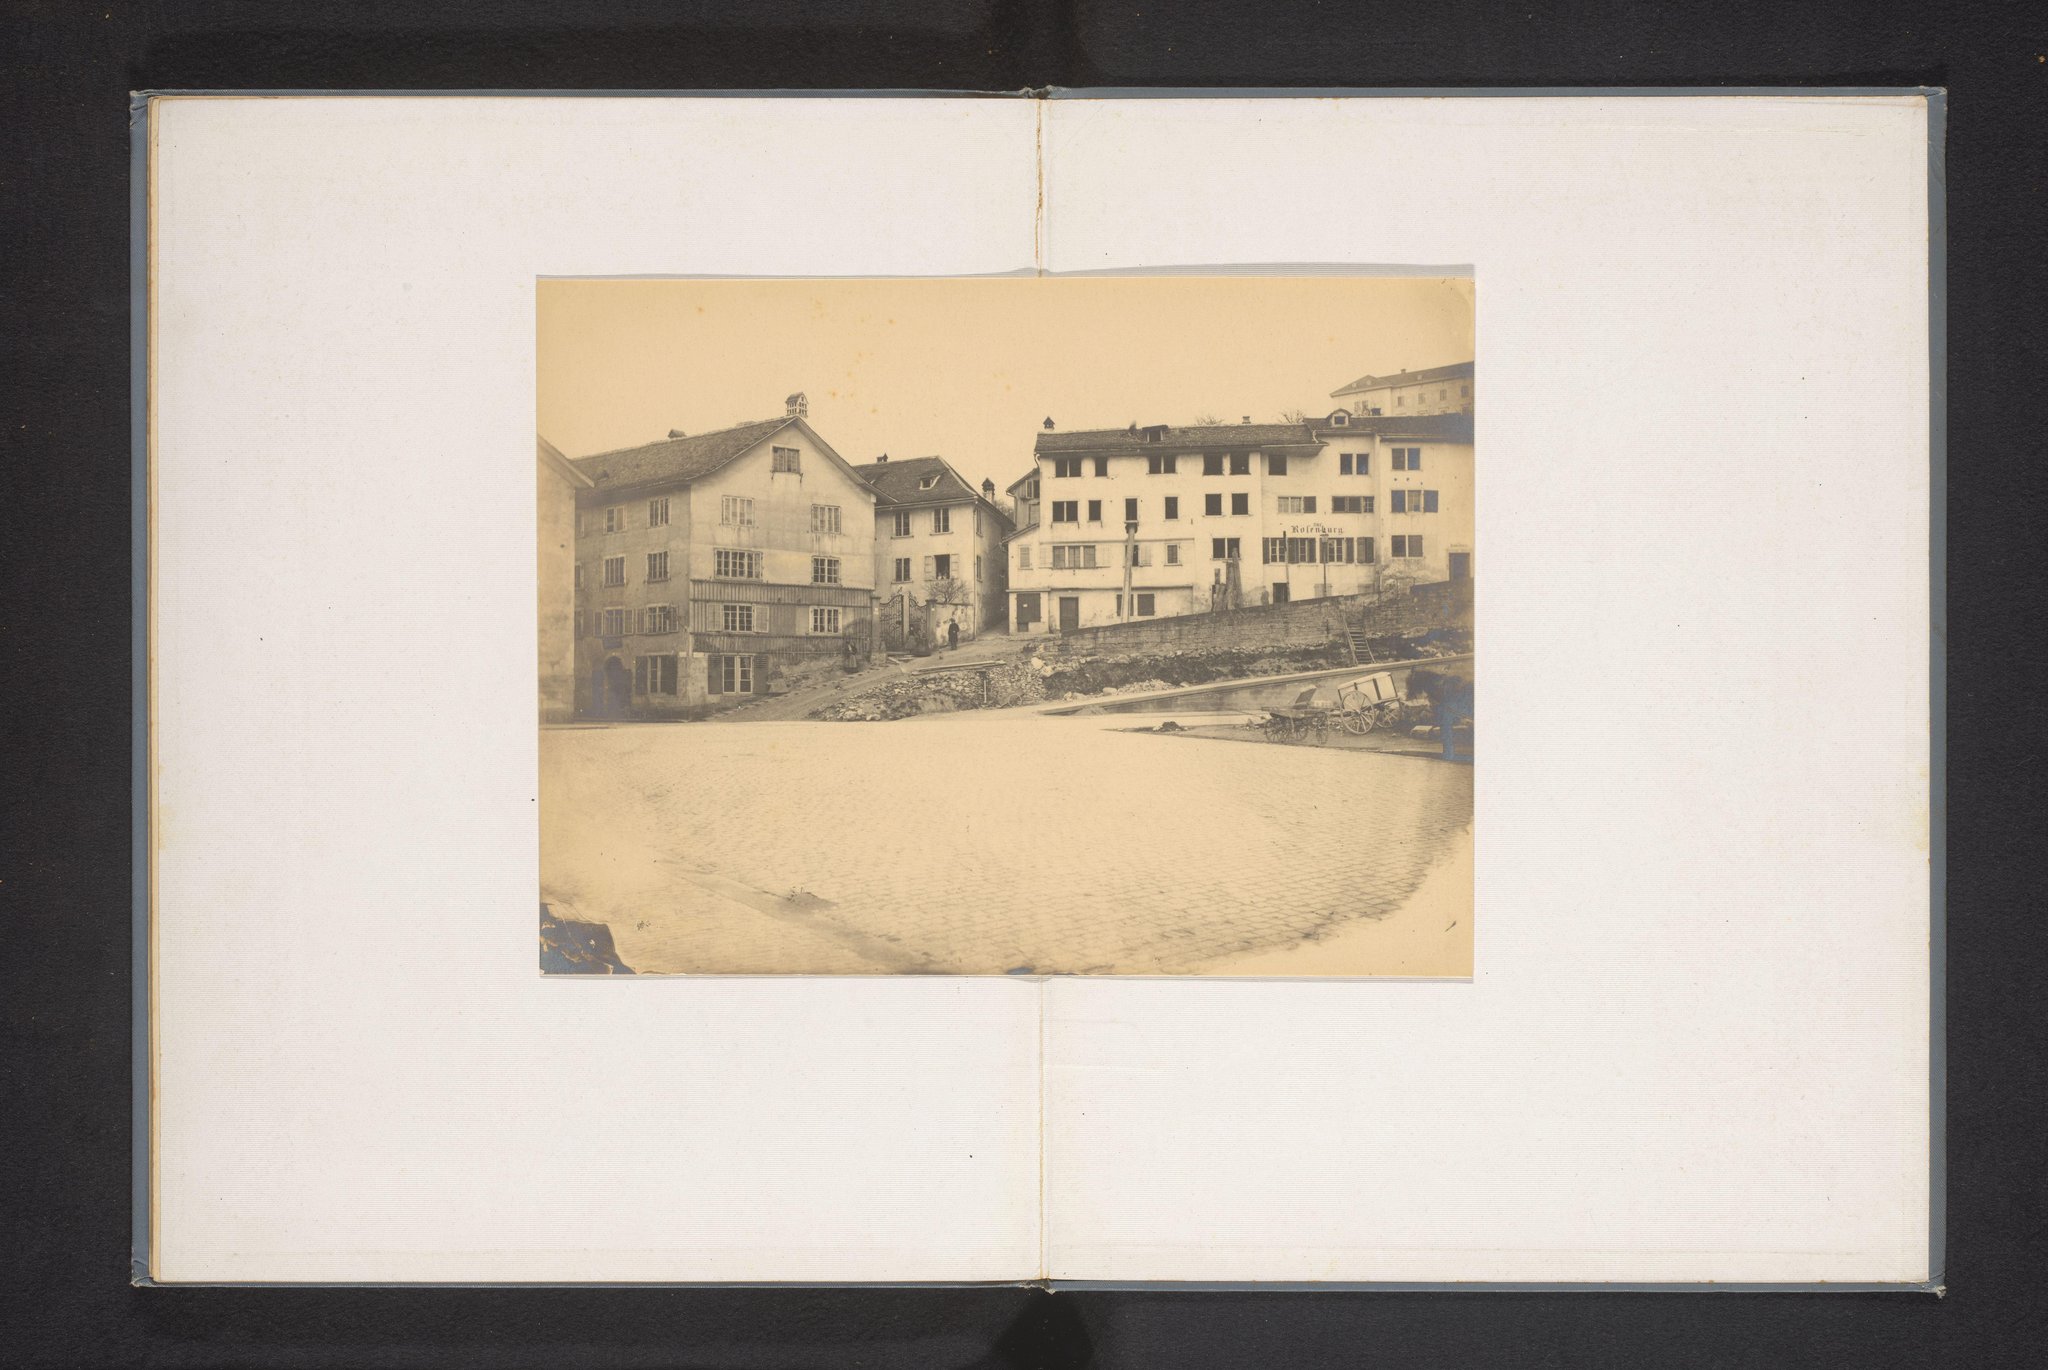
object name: page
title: Gezicht op een straat met vermoedelijk een hotel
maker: Anonymous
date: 1883-1914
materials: photographic support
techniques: gelatin silver print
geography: europe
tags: two-wheeled, animal-drawn vehicle, hotel, hostelry, inn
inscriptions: inscription: ‘[...] errinerung [...]Hochzeitstag[...] Salomon Nanny [...] Zurich 20 may 1914’